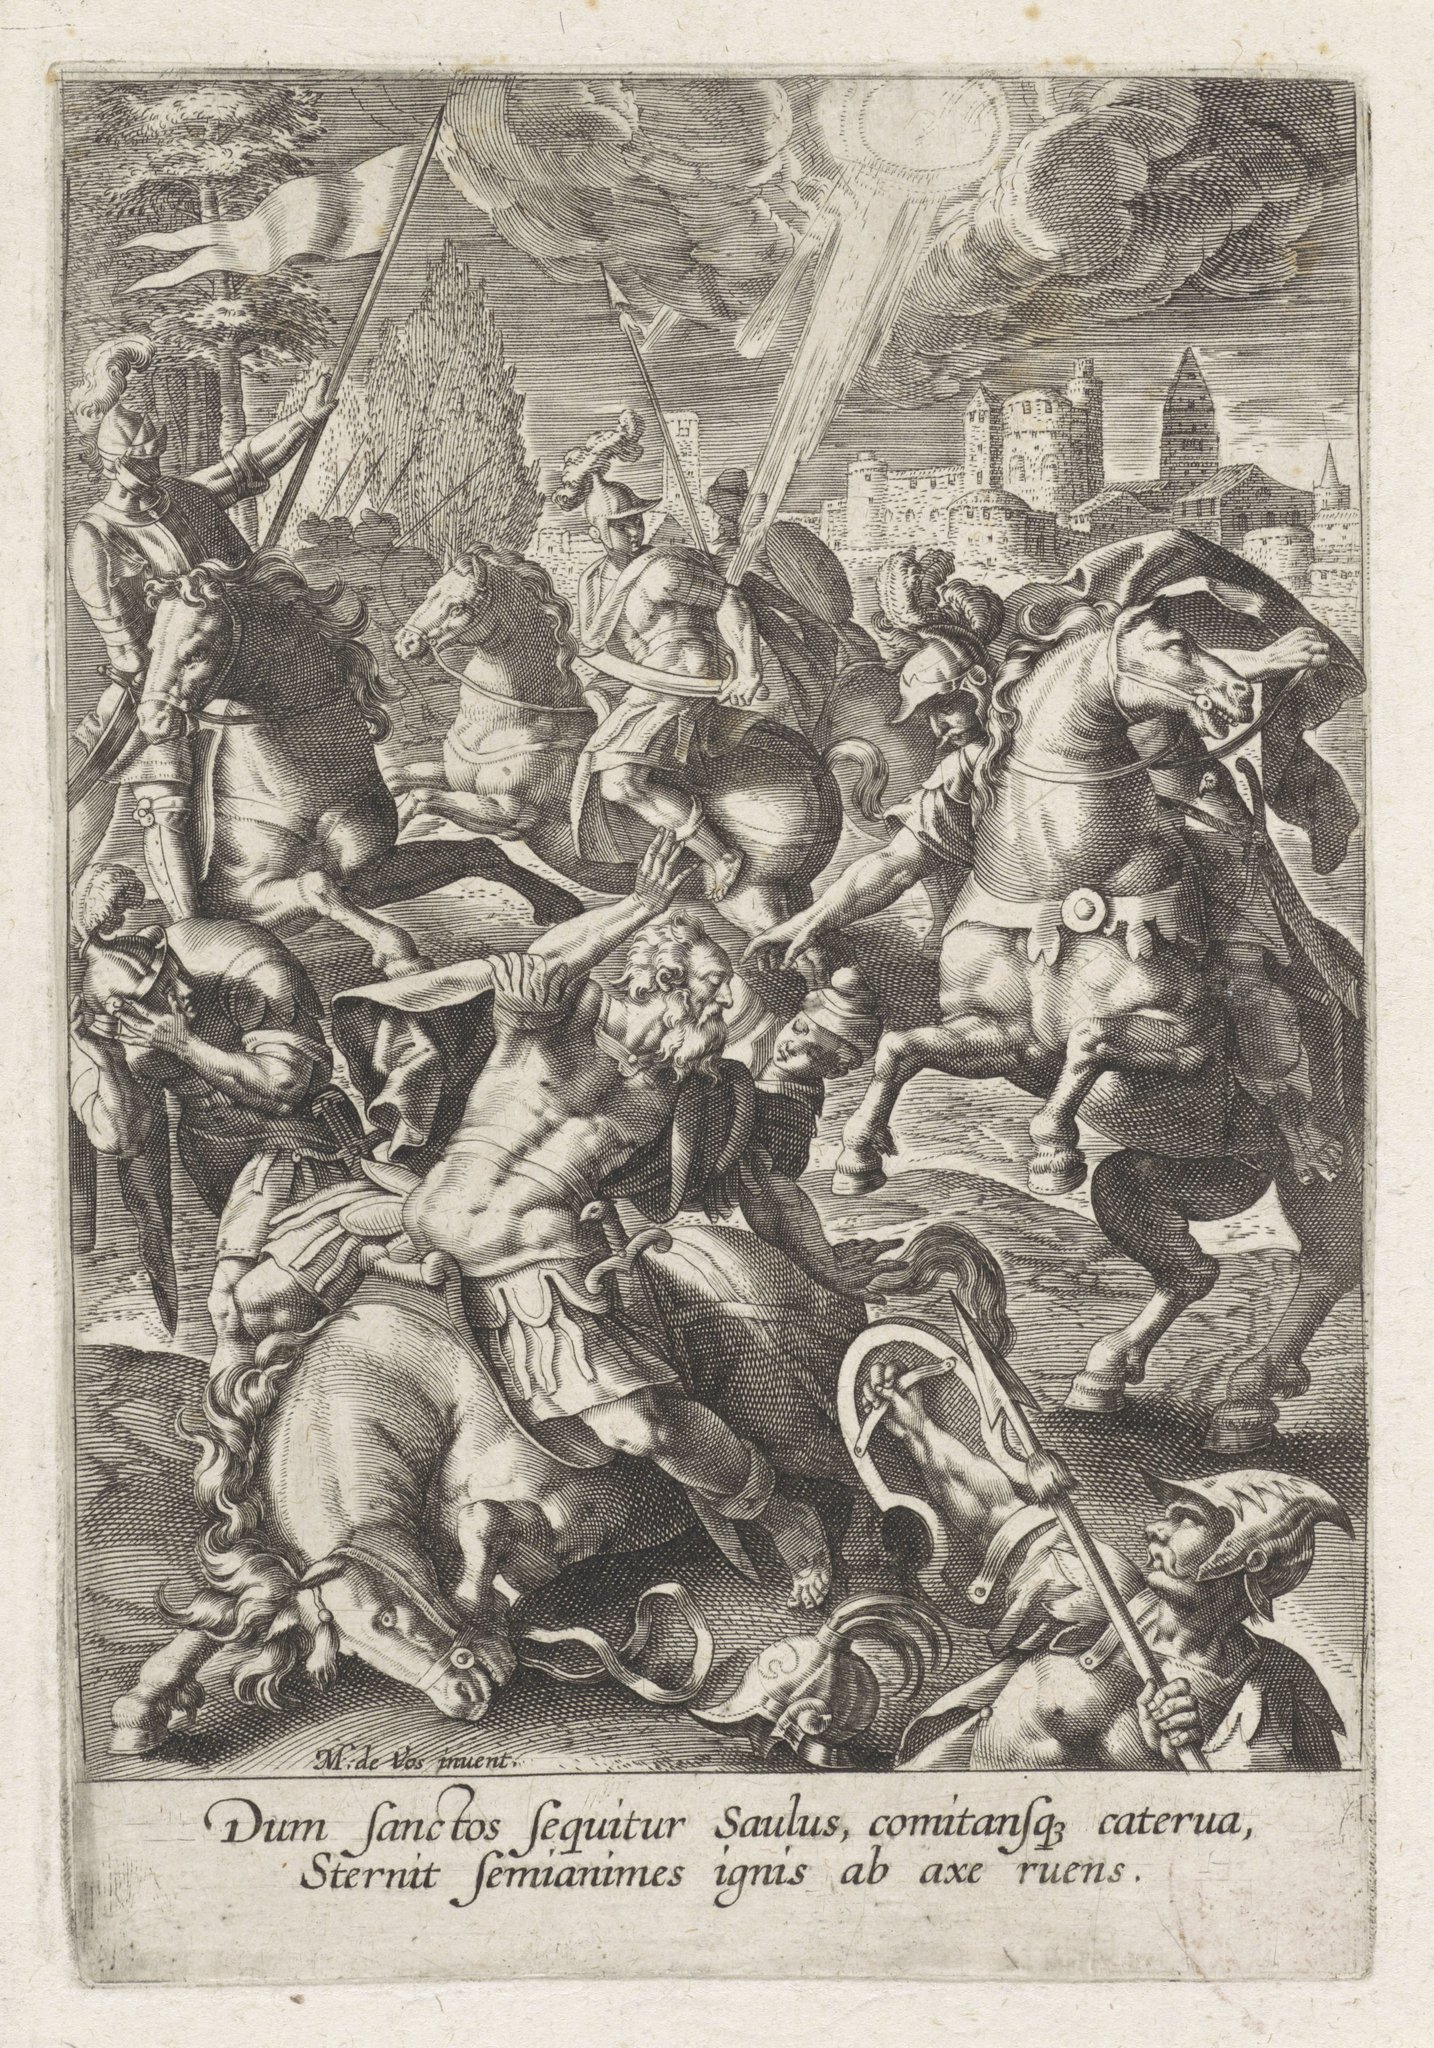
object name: print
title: Handelingen van de apostelen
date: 1591-1600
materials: paper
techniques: engraving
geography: antwerp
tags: on the way to damascus christ appears to saul, who falls from his horse and is blinded by the light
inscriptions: collector's mark: Lugt 240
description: Saul, de latere apostel Paulus, wordt onderweg naar Damascus verblind door licht uit de hemel, waardoor hij van zijn paard valt. Andere soldaten te paard snellen toe om hem te helpen. Onder in de marge een tweeregelig onderschrift in het Latijn.